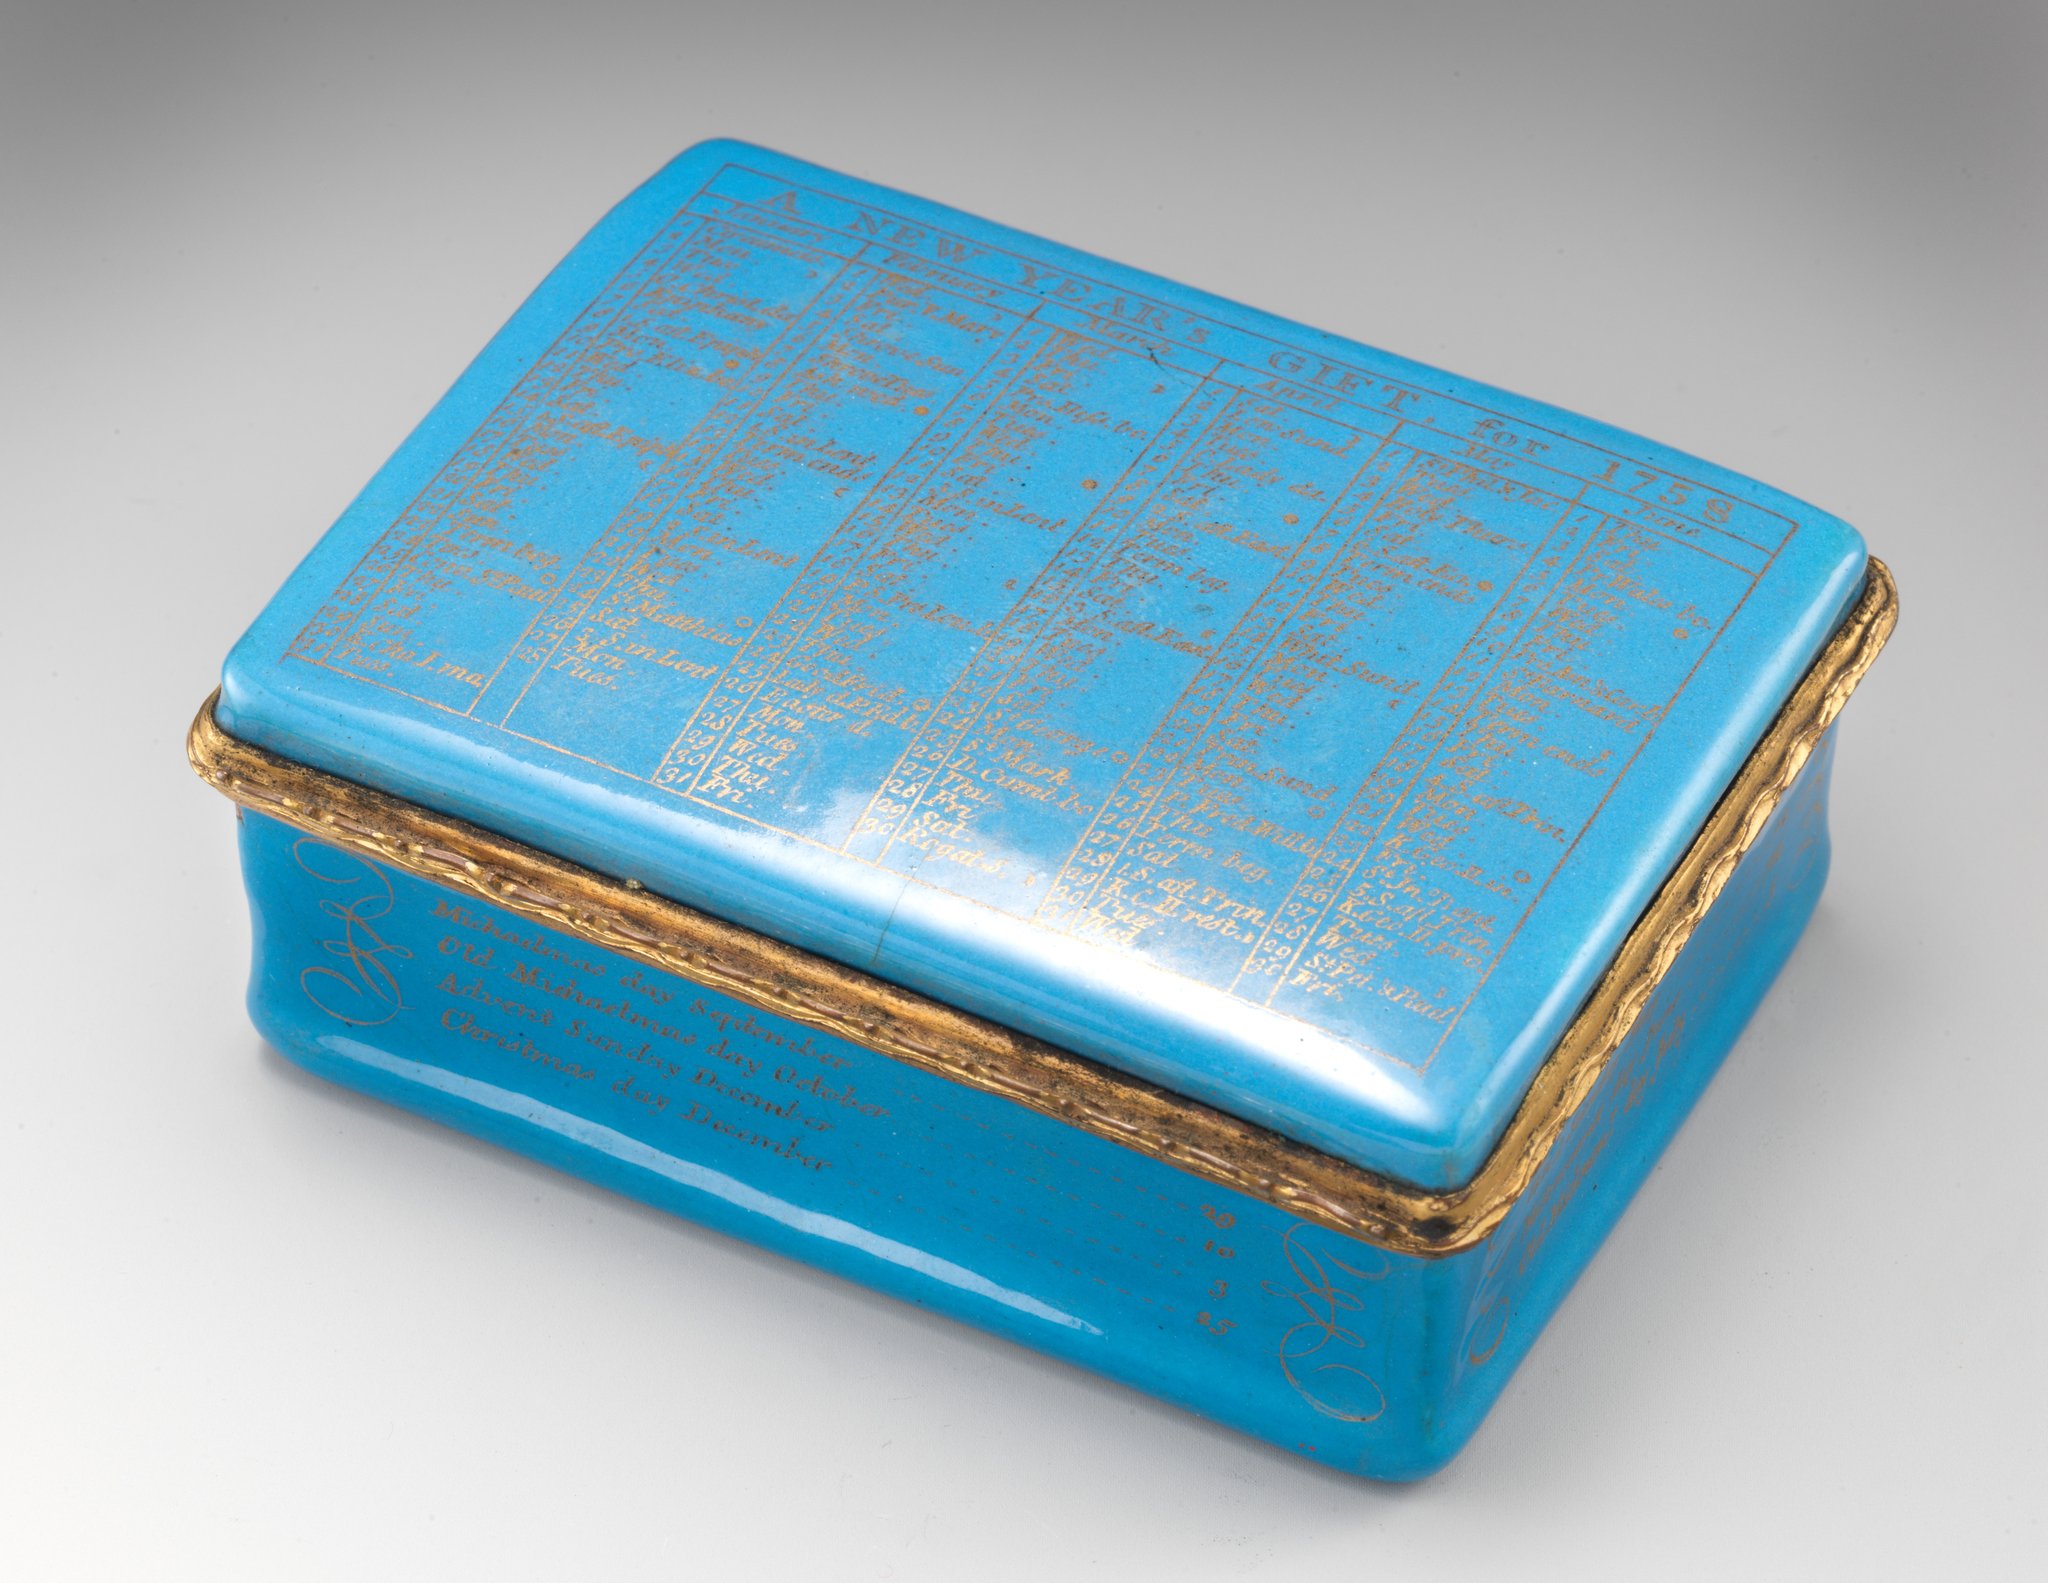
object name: snuffbox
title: Snuffbox with calendar and saints' days for 1758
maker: anthony tregent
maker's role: enameler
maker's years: 1700-1800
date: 1757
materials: copper, enamel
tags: calendars